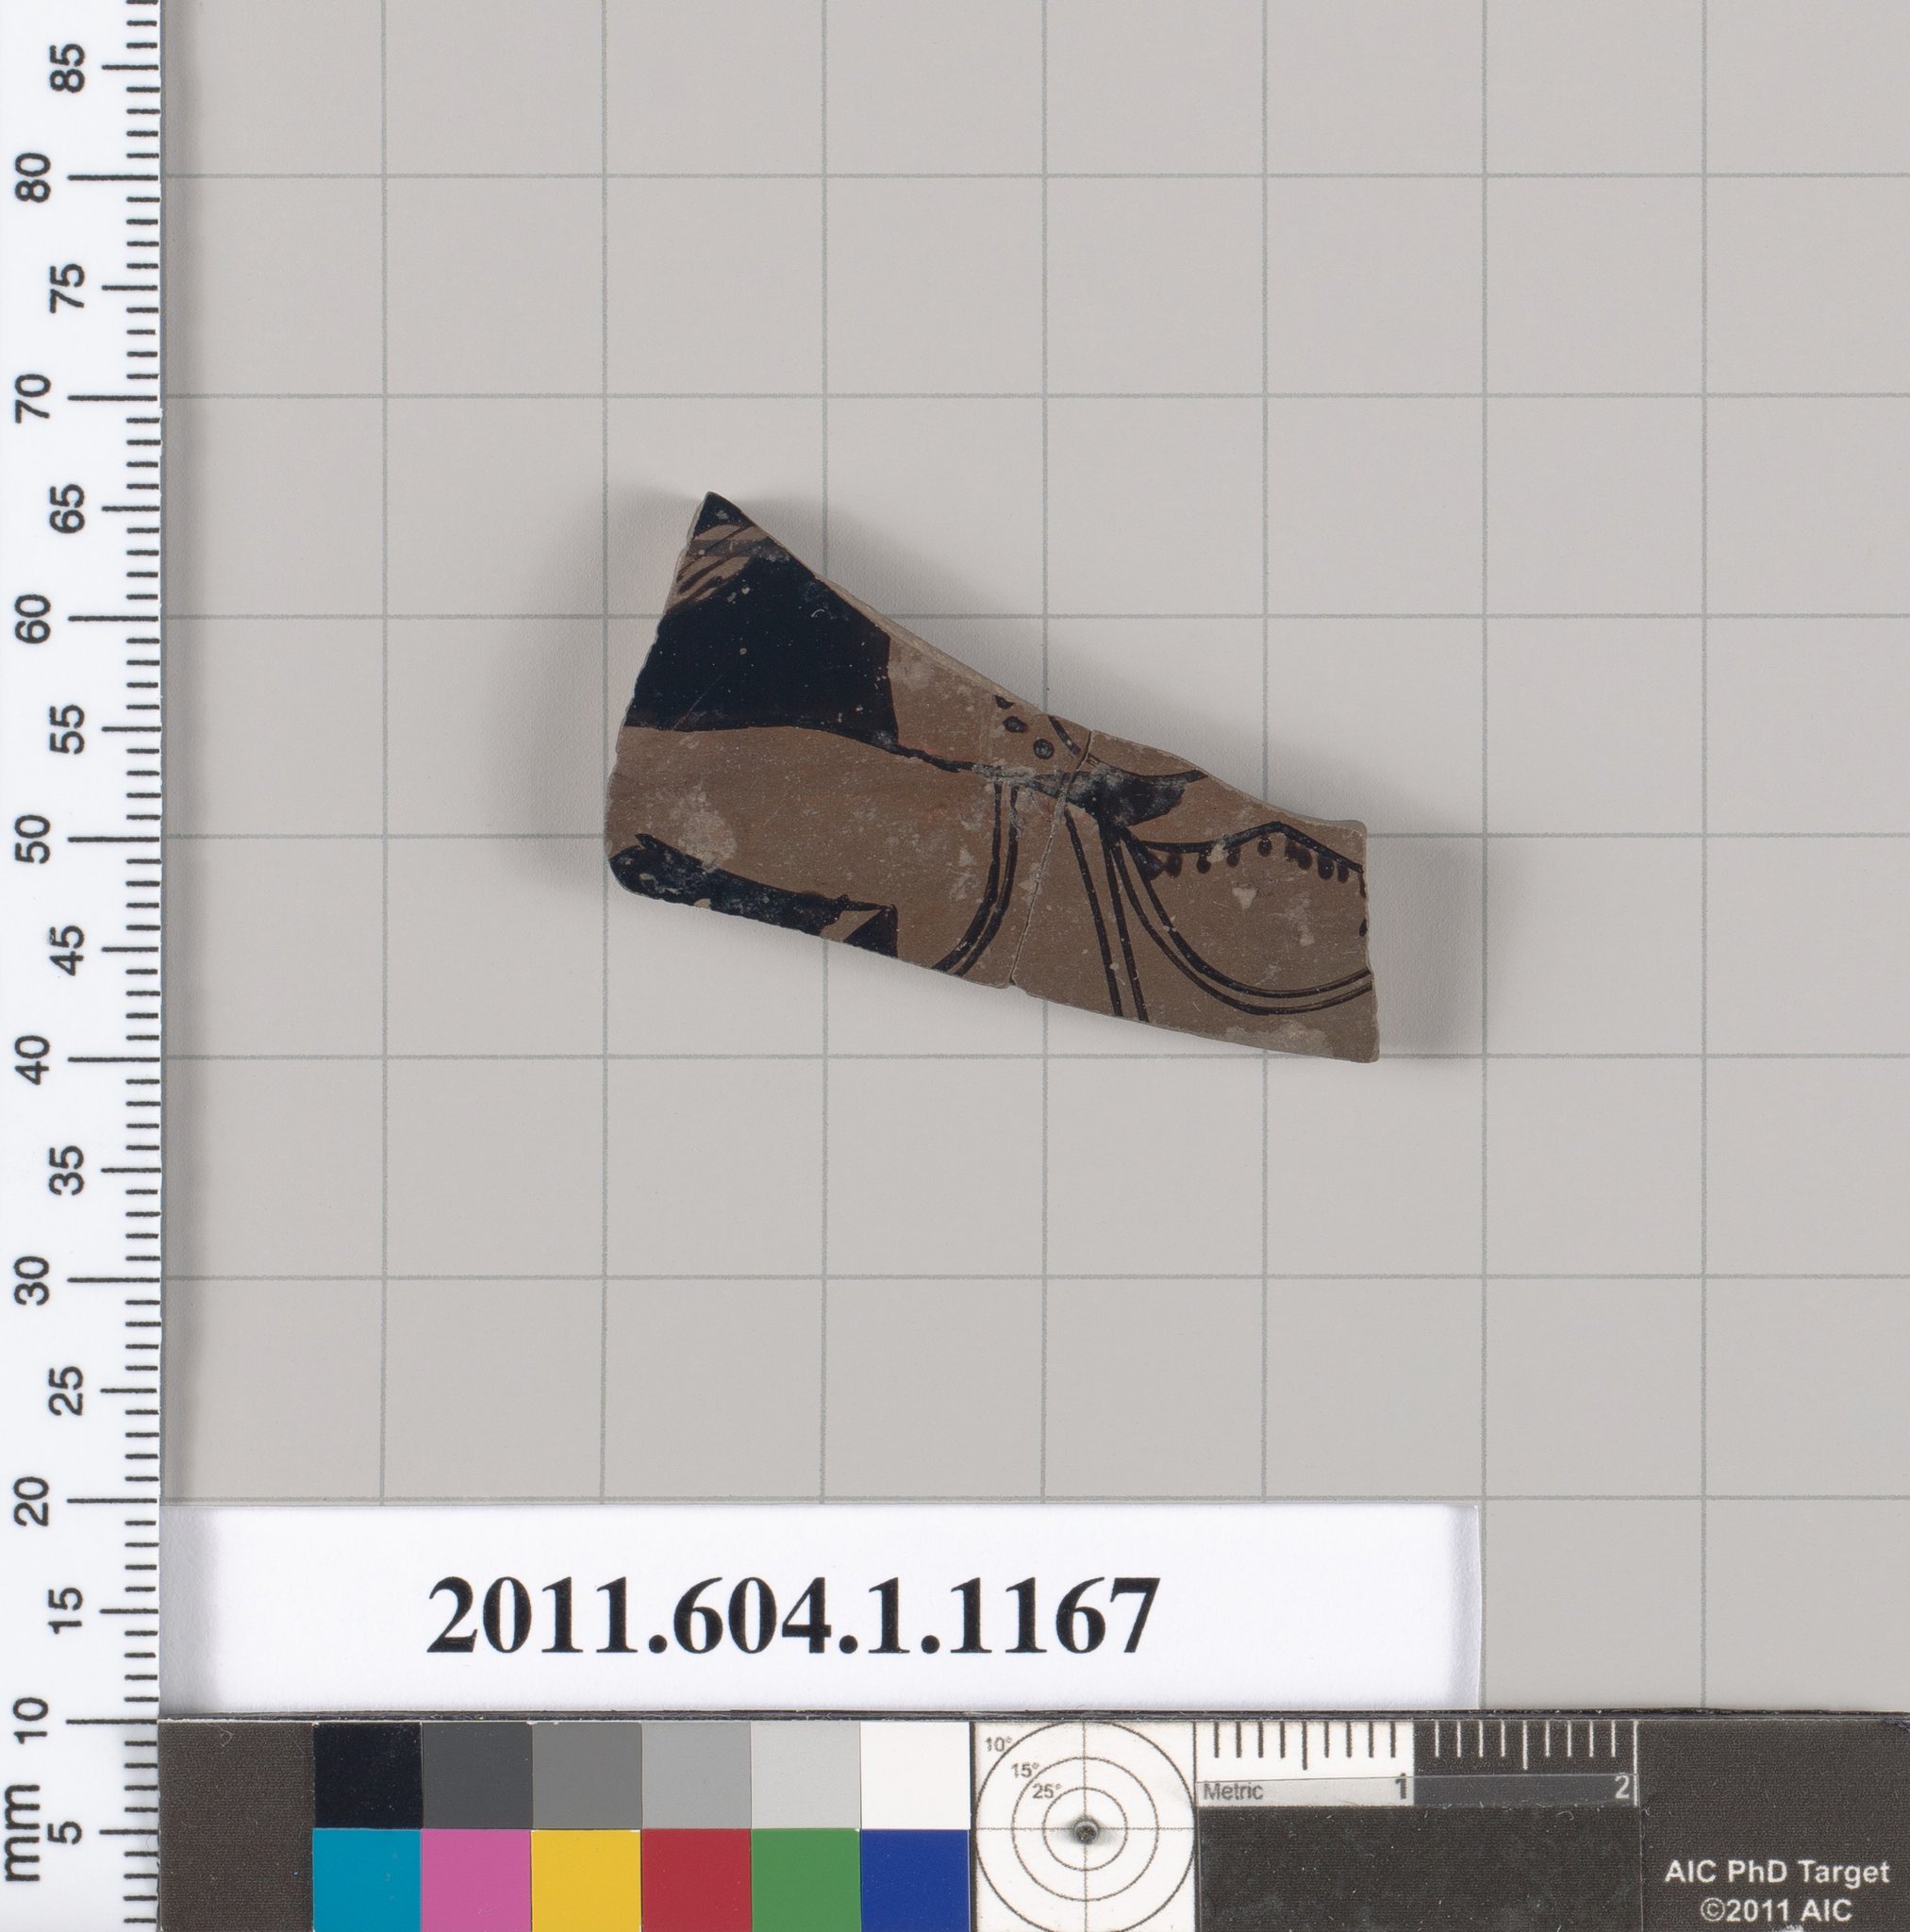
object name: kylix fragment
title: Terracotta fragment of a kylix (drinking cup)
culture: greek, attic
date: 520-500 BCE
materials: terracotta